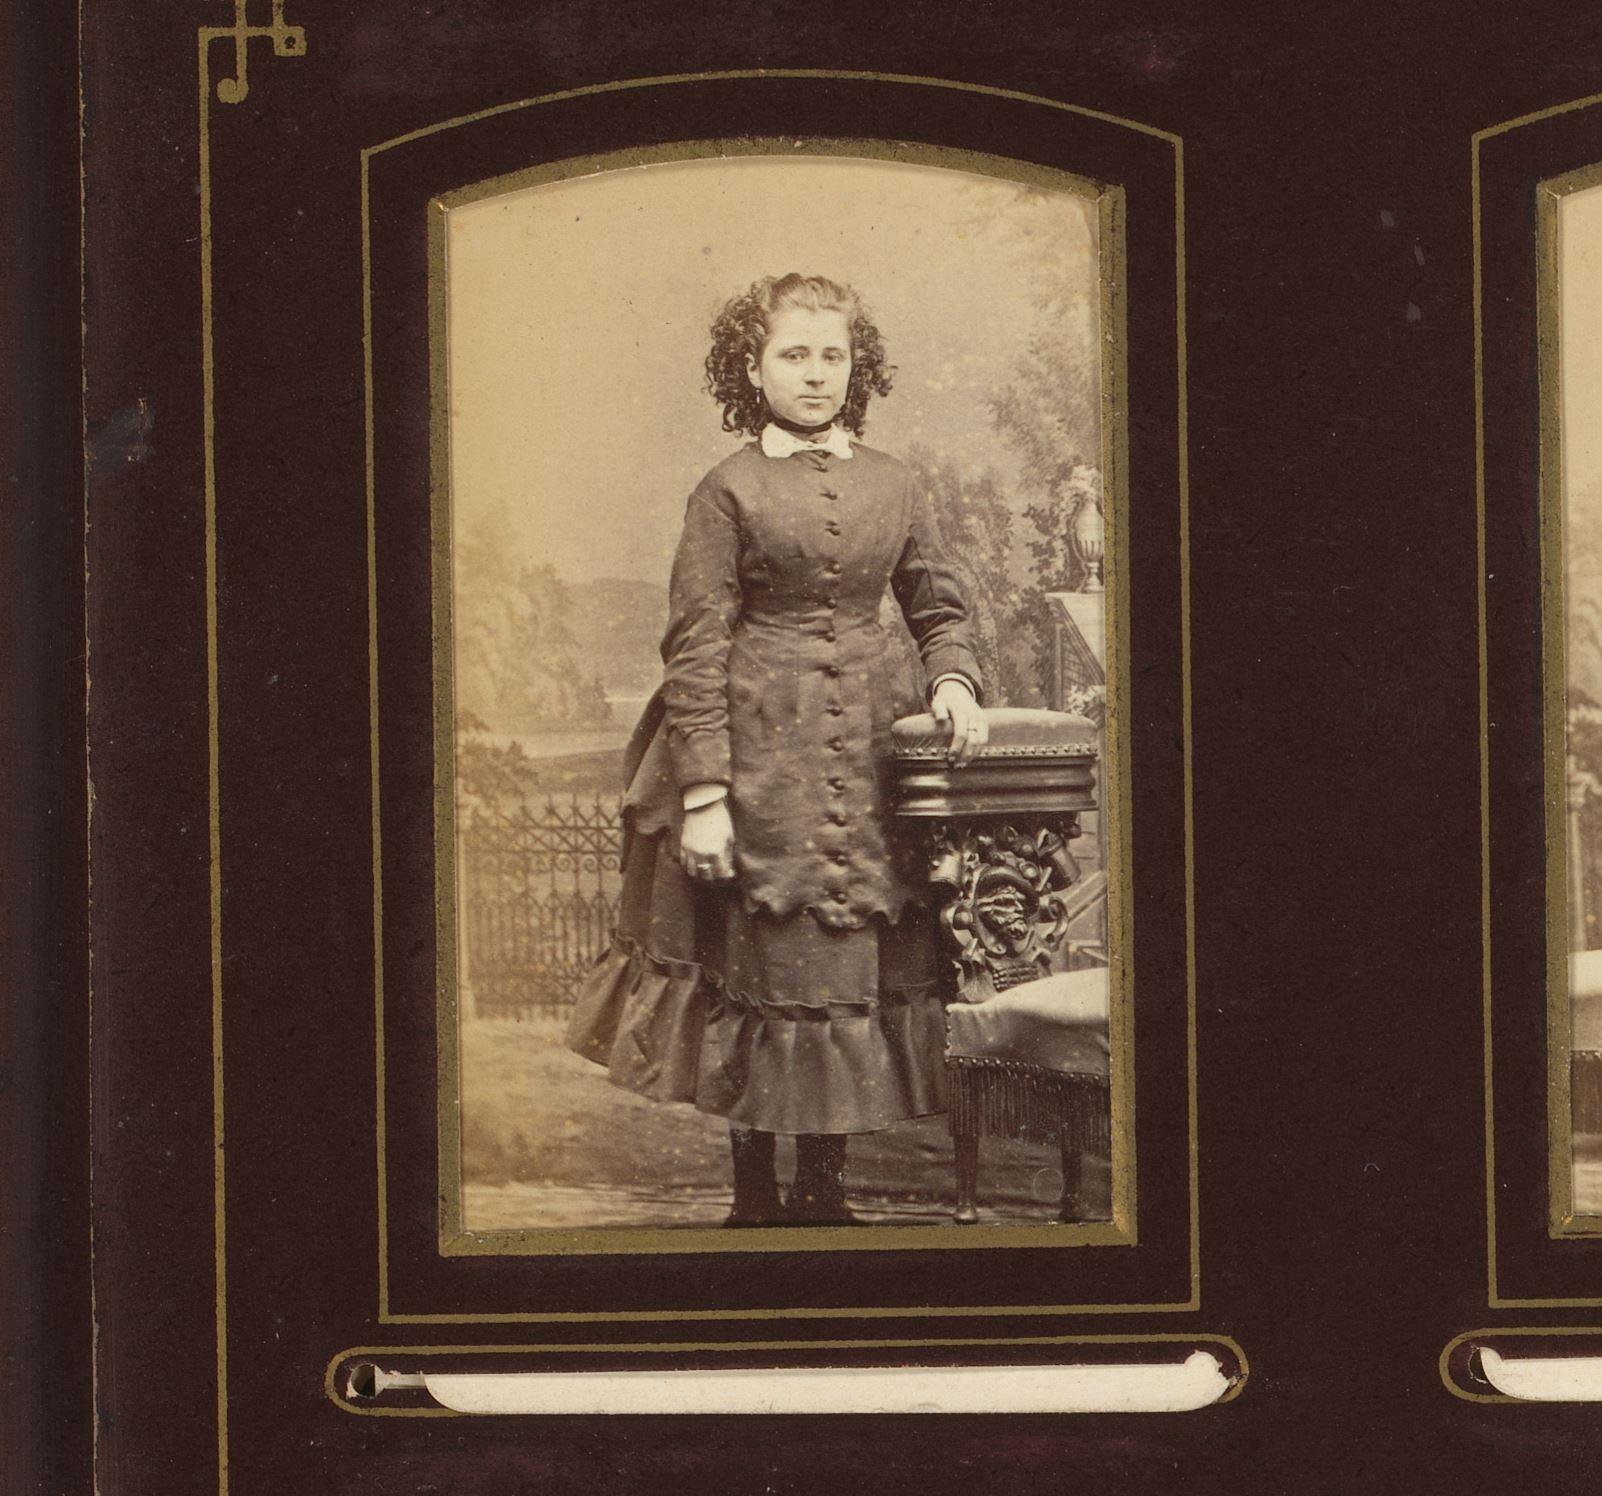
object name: photograph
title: Portret van een jonge vrouw, staand bij een stoel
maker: pieter vlaanderen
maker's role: fotograaf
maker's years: 1840-1878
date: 1867-1874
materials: cardboard, photographic support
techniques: albumen print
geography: alkmaar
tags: adolescent, young woman, maiden, historical persons - bb - woman, chair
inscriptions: inscription: ‘P.V./ ATELIER DE REMBRANDT/ van/ P. VLAANDEREN/ Verdronken Oord/ Wyk D. No. 34./ ALKMAAR.’